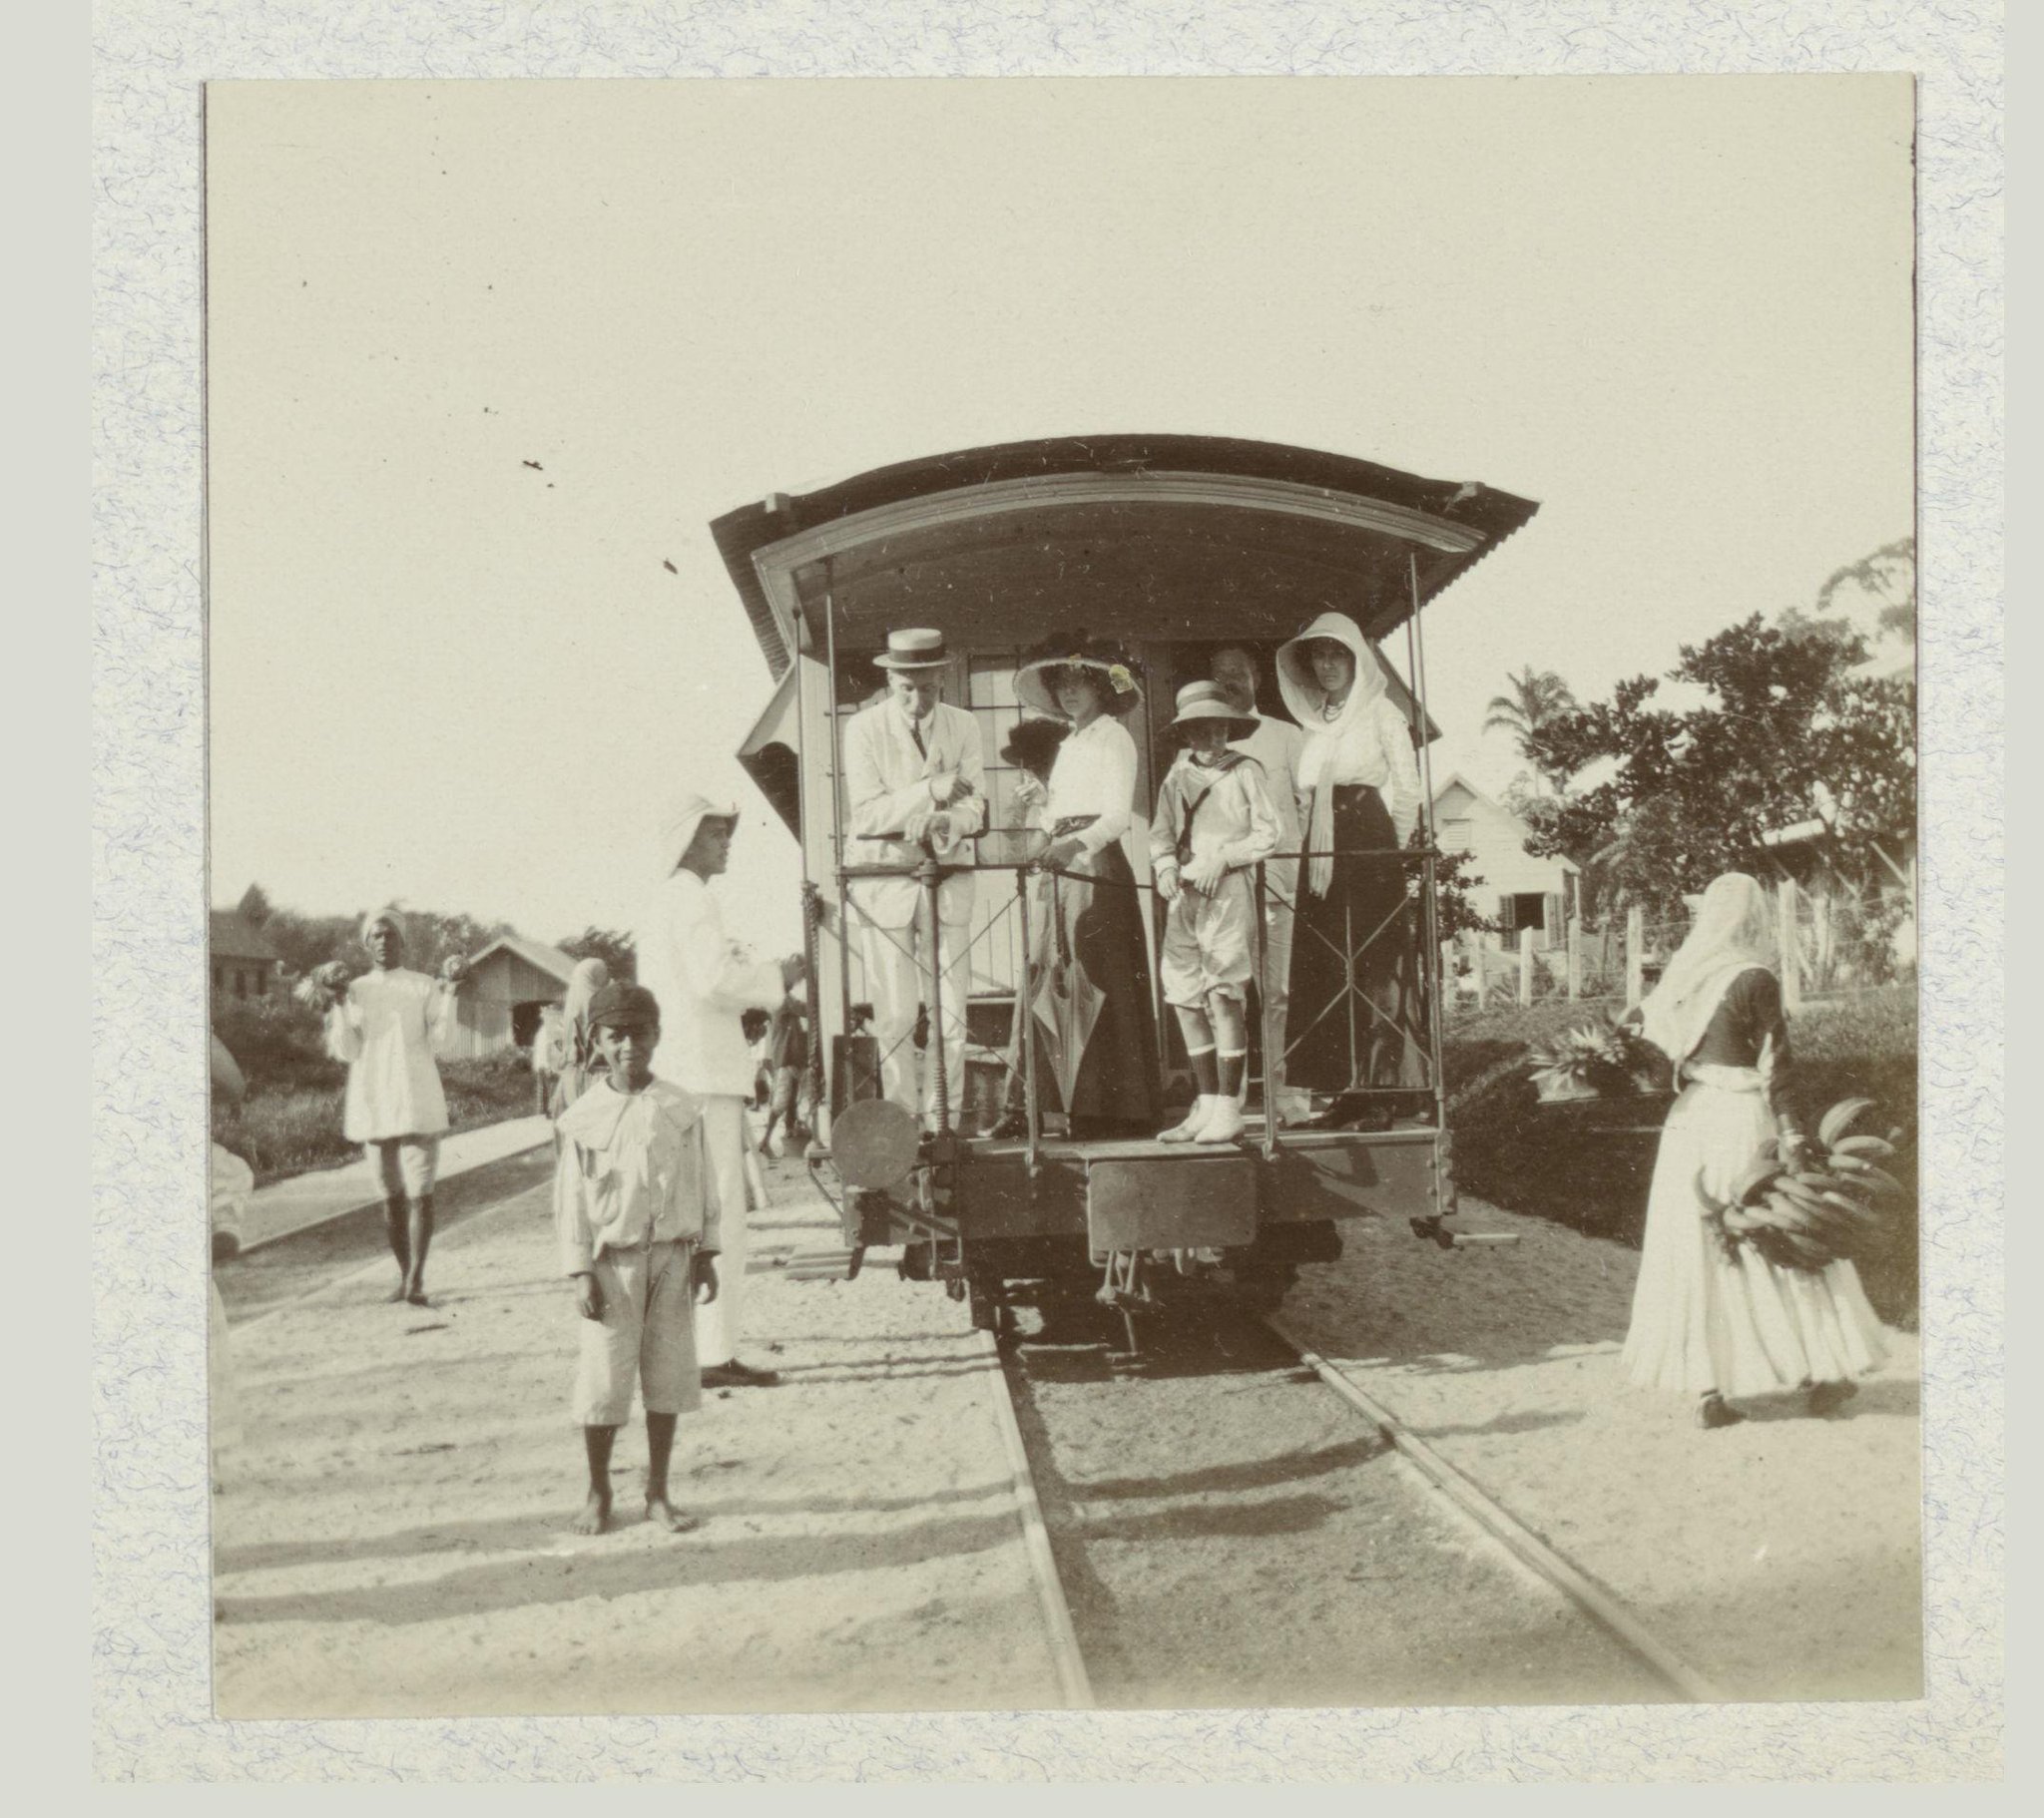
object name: photograph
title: Op de trein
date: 1911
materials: photographic support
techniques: photography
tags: passenger train, suriname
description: Een gezelschap, waaronder Andries Boom en Maria Gonggrijp, staande op de achterbalkon van een trein. Bij de trein enkele verkopers van fruit: ananassen en bananen. Onderdeel van het fotoalbum van de familie Boom-Gonggrijp in Suriname en Curaçao.